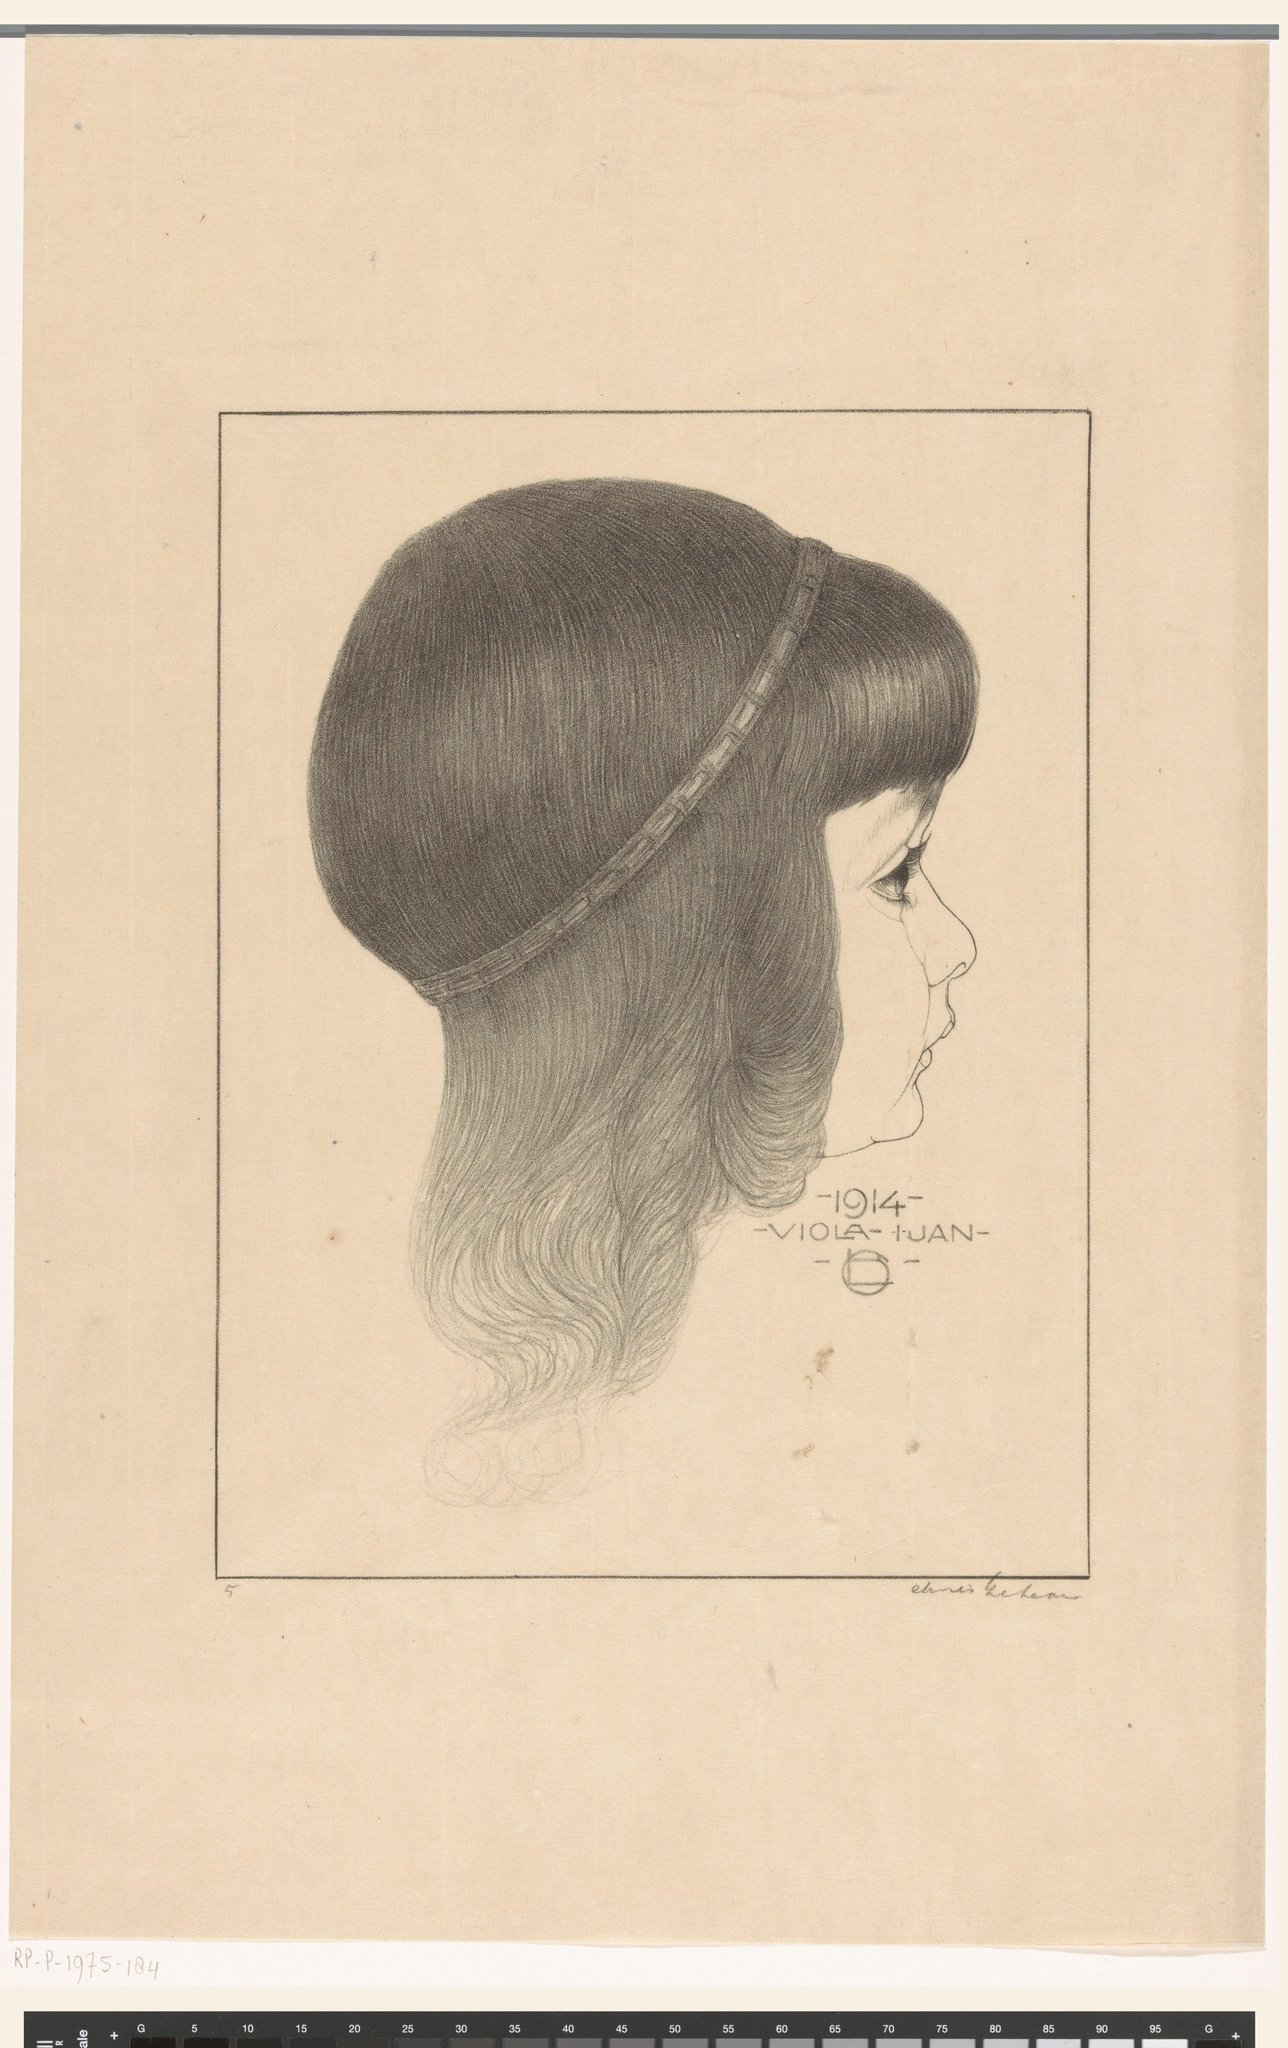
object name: print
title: Portret van Viola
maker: chris lebeau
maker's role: draughtsman, print maker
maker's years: 1878-1945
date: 1914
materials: paper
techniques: lithograph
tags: girl (child between toddler and youth)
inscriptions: collector's mark: Lugt 2228, collector's mark: Lugt 2760